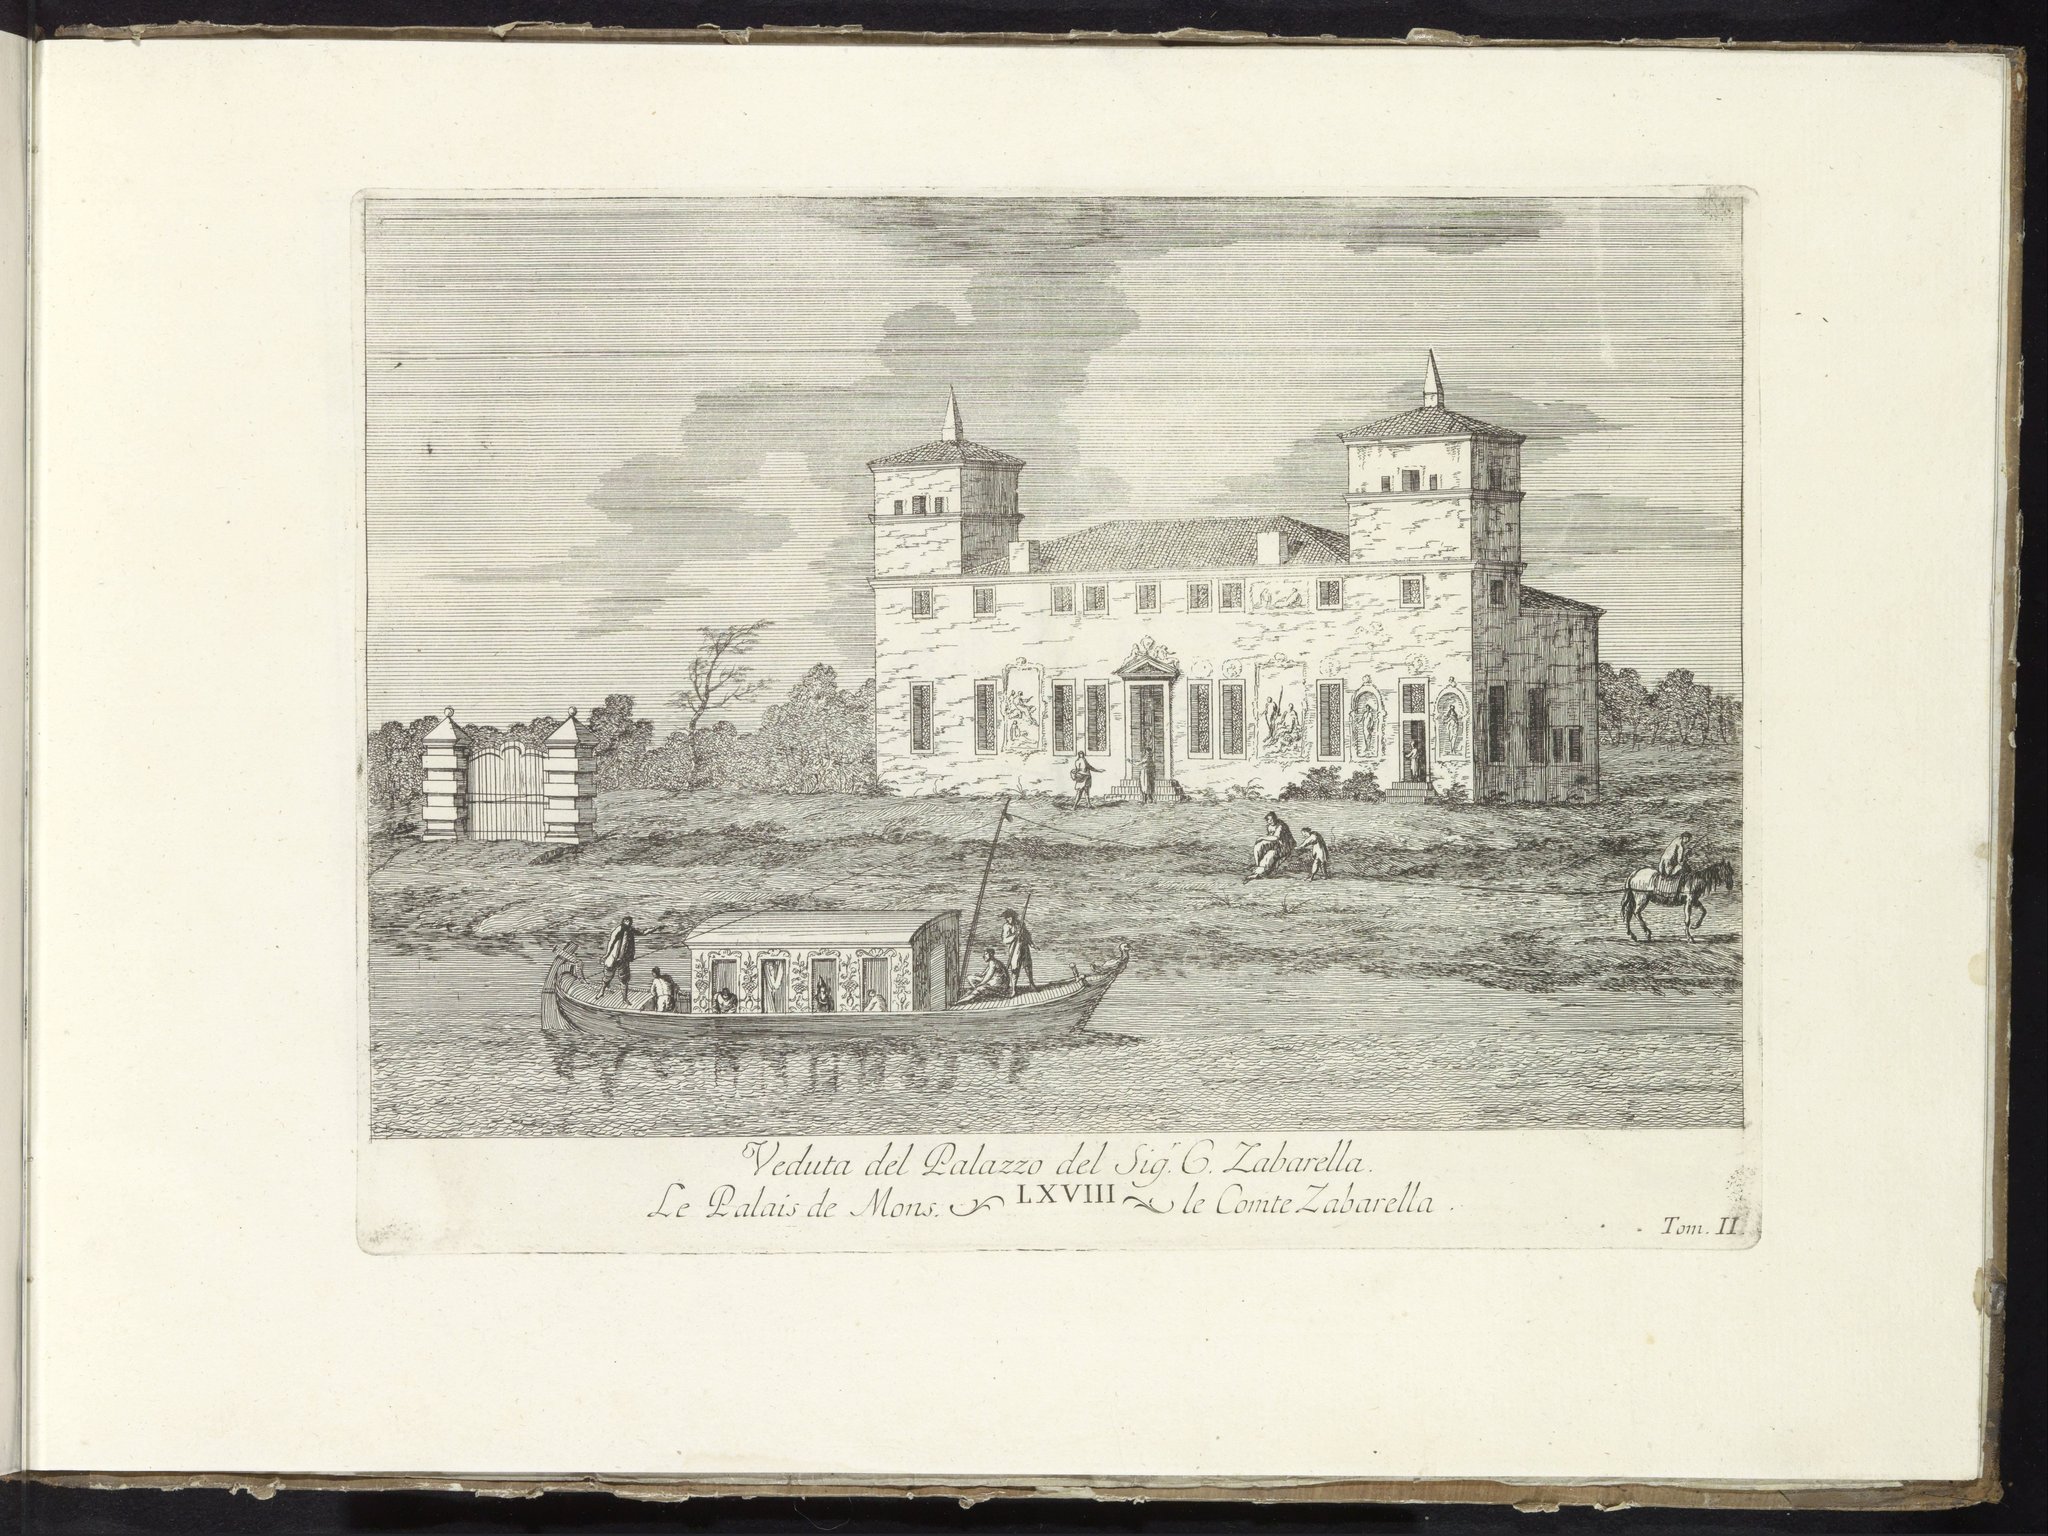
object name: print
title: Palazzo del Signore C. Zabarella aan de Brenta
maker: giovanni francesco costa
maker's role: draughtsman, painter, print maker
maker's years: -1773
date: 1750-1760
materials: paper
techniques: etching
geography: venice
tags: river, tow-boat, towing-barge, hôtel, i.e. small palace in city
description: Gezicht op Palazzo del Signore C. Zabarella aan de rivier de Brenta. Op het water vaart een trekschuit. Genummerd midden onder: VIII en rechtsonder: Tom: II. Deze prent maakt deel uit van een album.